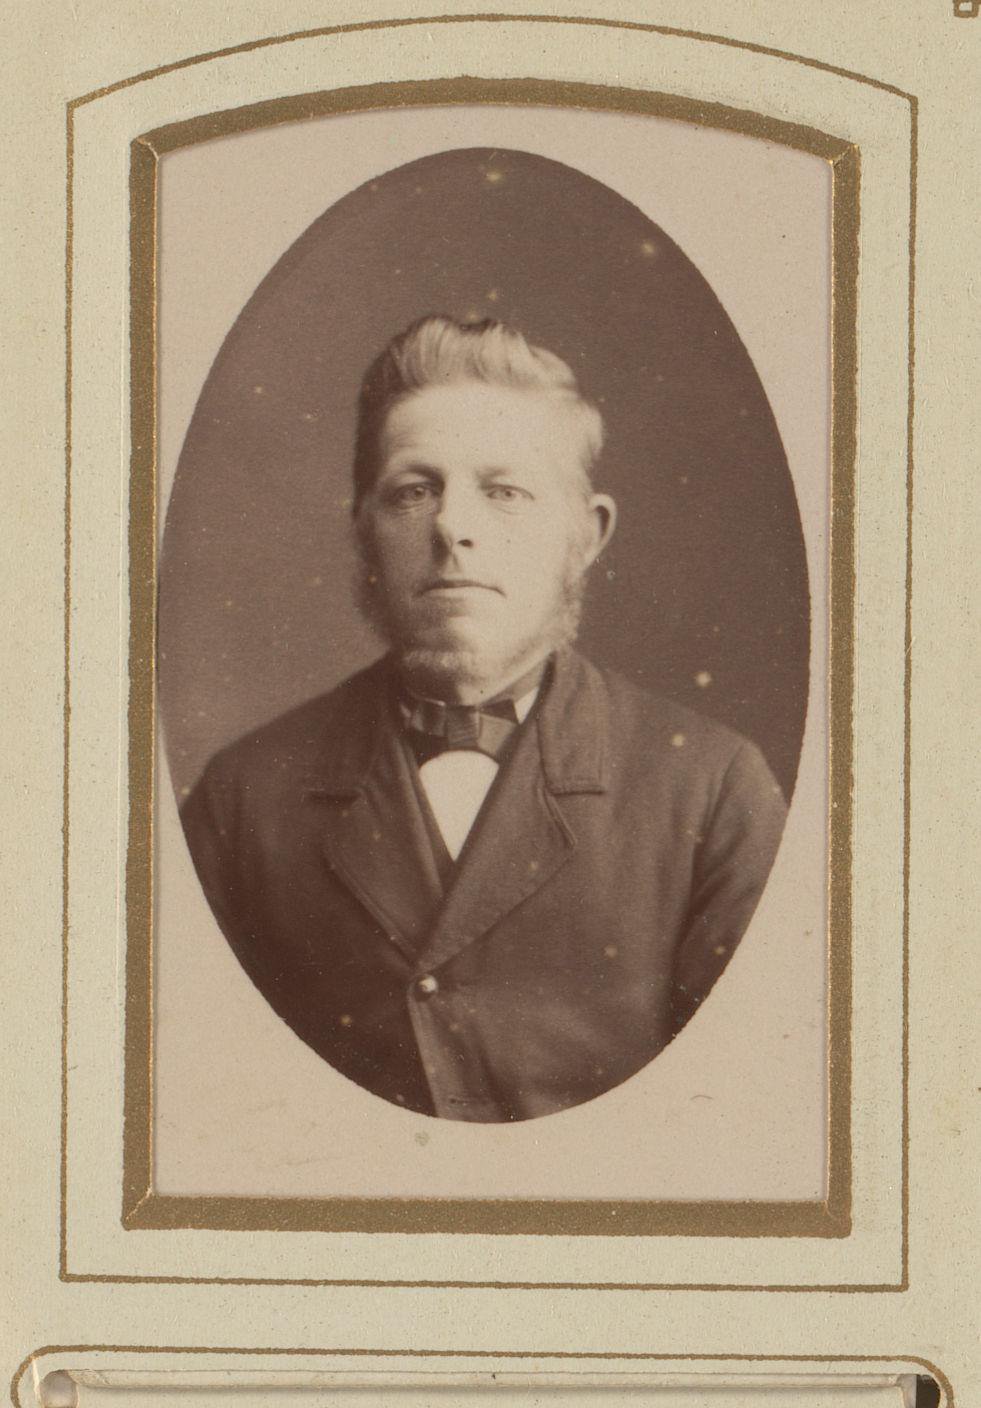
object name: carte de visite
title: Portret van een man met baard en vlinderstrik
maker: willem gerhardus kuijer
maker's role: fotograaf, hoffotograaf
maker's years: 1834-1899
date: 1862-1899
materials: cardboard, photographic support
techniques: albumen print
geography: amsterdam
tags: historical persons, beard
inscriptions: inscription: ‘Photographie/ instantanée./ W. G. Kuijer/ Westermarkt/ 19/ Amsterdam./ Speciale inrichting voor vergrootingen/ in alle formaten.’, number: ‘18’